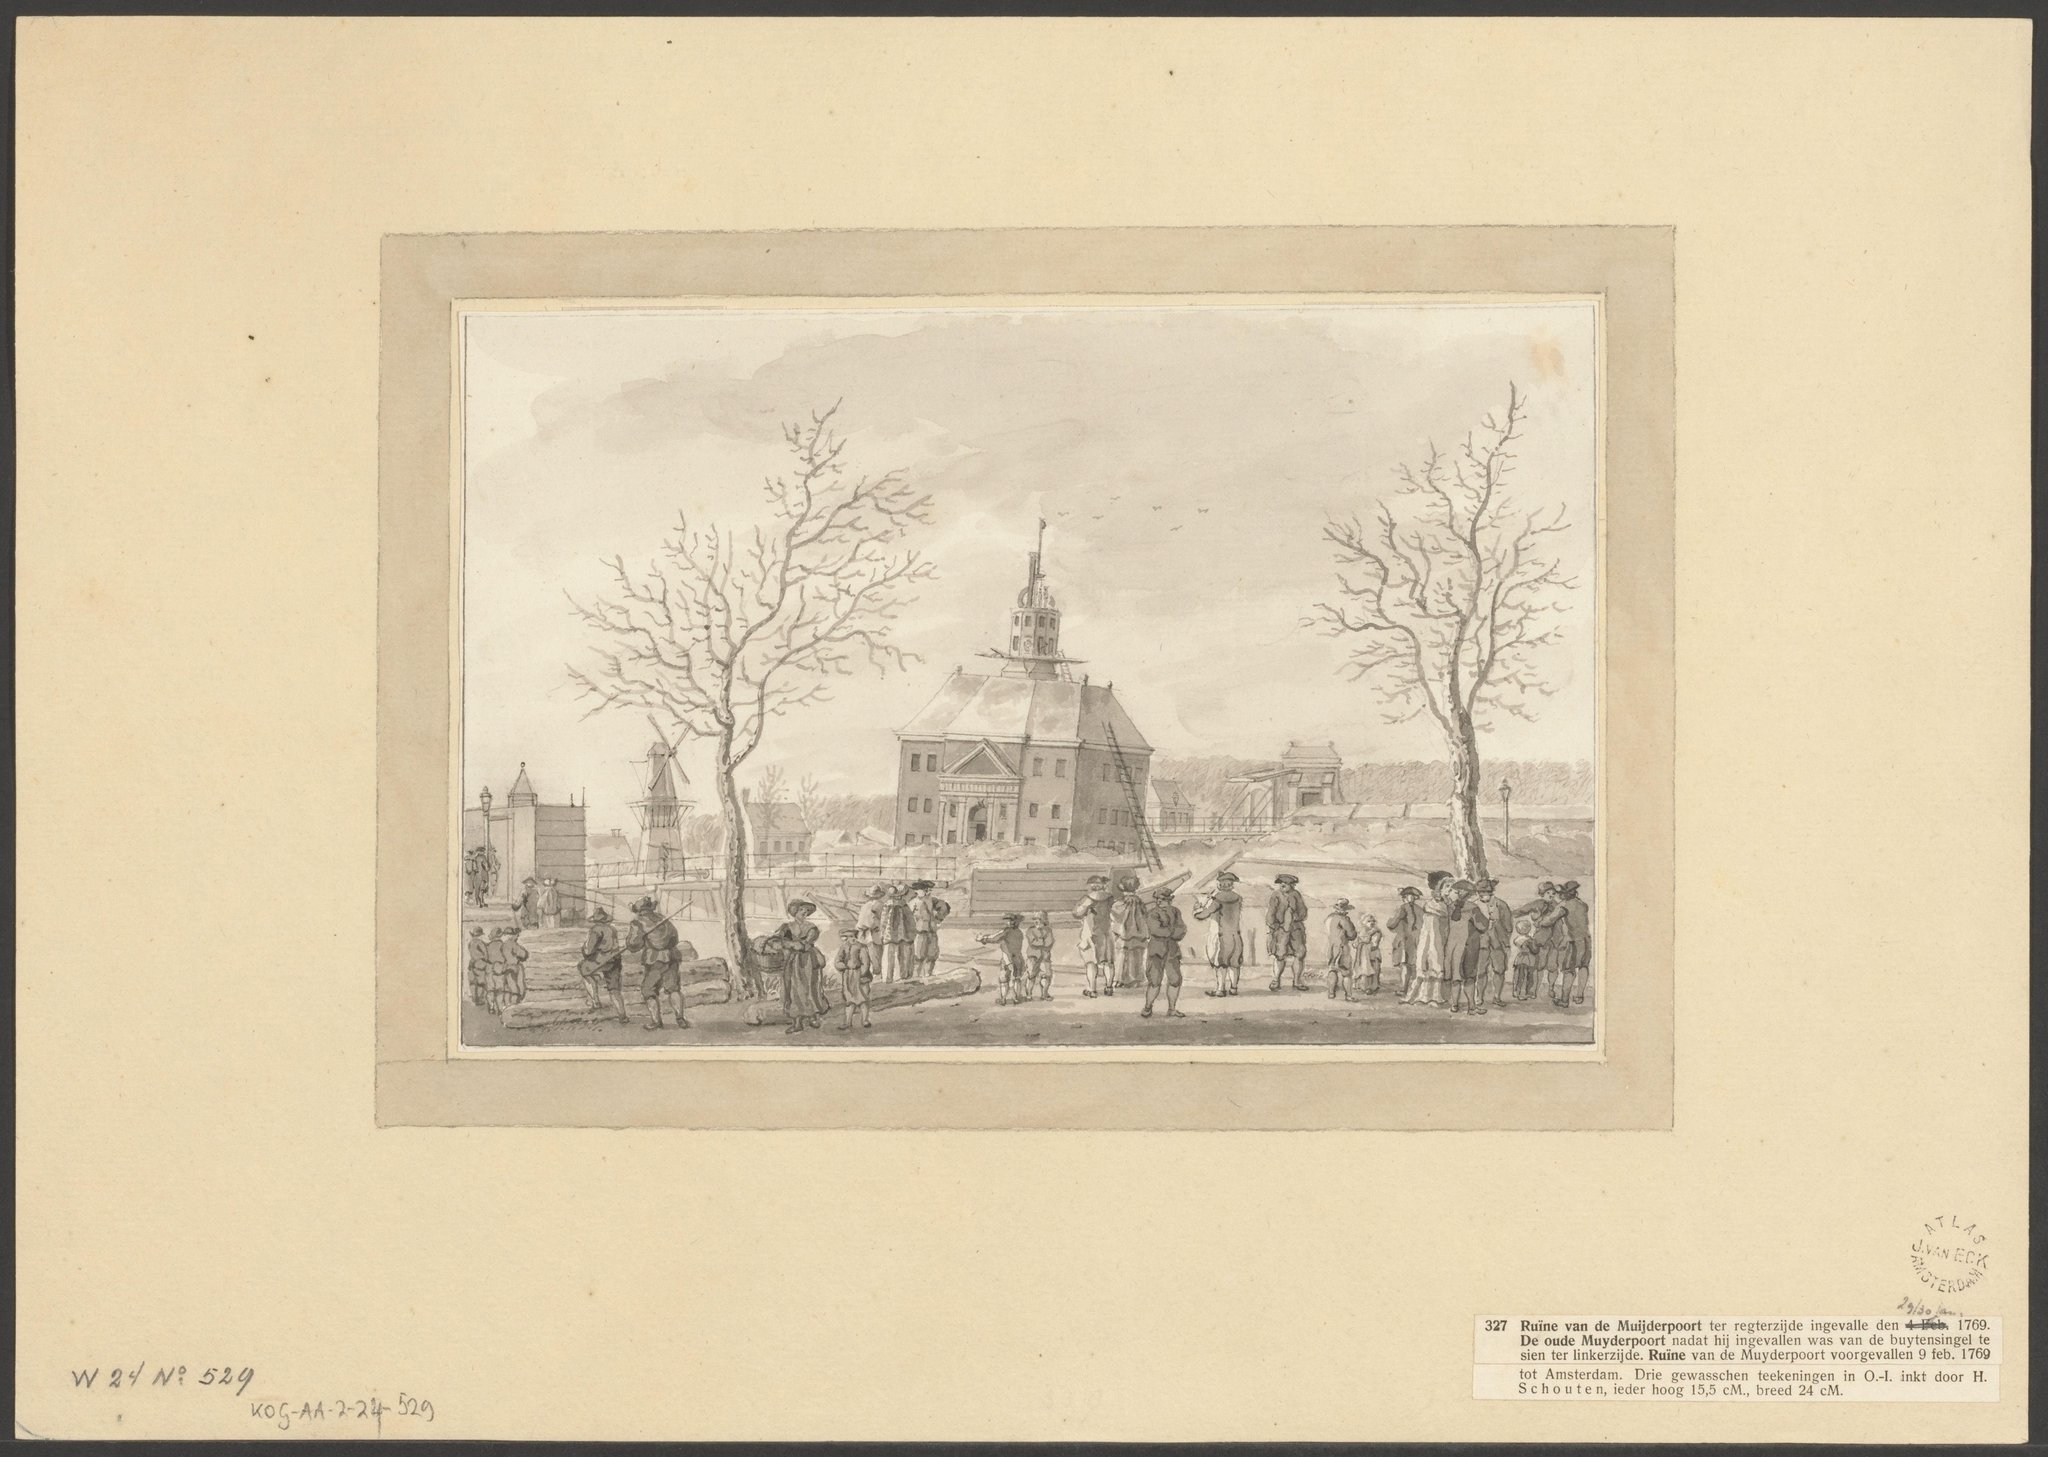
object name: drawing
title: Gezicht op de eerste Muiderpoort na de verzakking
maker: hermanus petrus schouten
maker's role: draughtsman, painter, print maker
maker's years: 1747-1822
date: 1769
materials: ink, paper, pencil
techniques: brush, pen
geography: amsterdam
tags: city-view in general; 'veduta', collapsing building, city-gate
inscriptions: inscription: ‘Ruinen van de muyderpoort / voorgevallen 4 feb 1769 tot amsterdam’, collector's mark: Lugt 800a, collector's mark: Lugt 800a, : ‘327 Ruïne van (...) breed 24 cM.’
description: Tekening binnen de Atlas Van Eck ingedeeld op wijknummer 24.